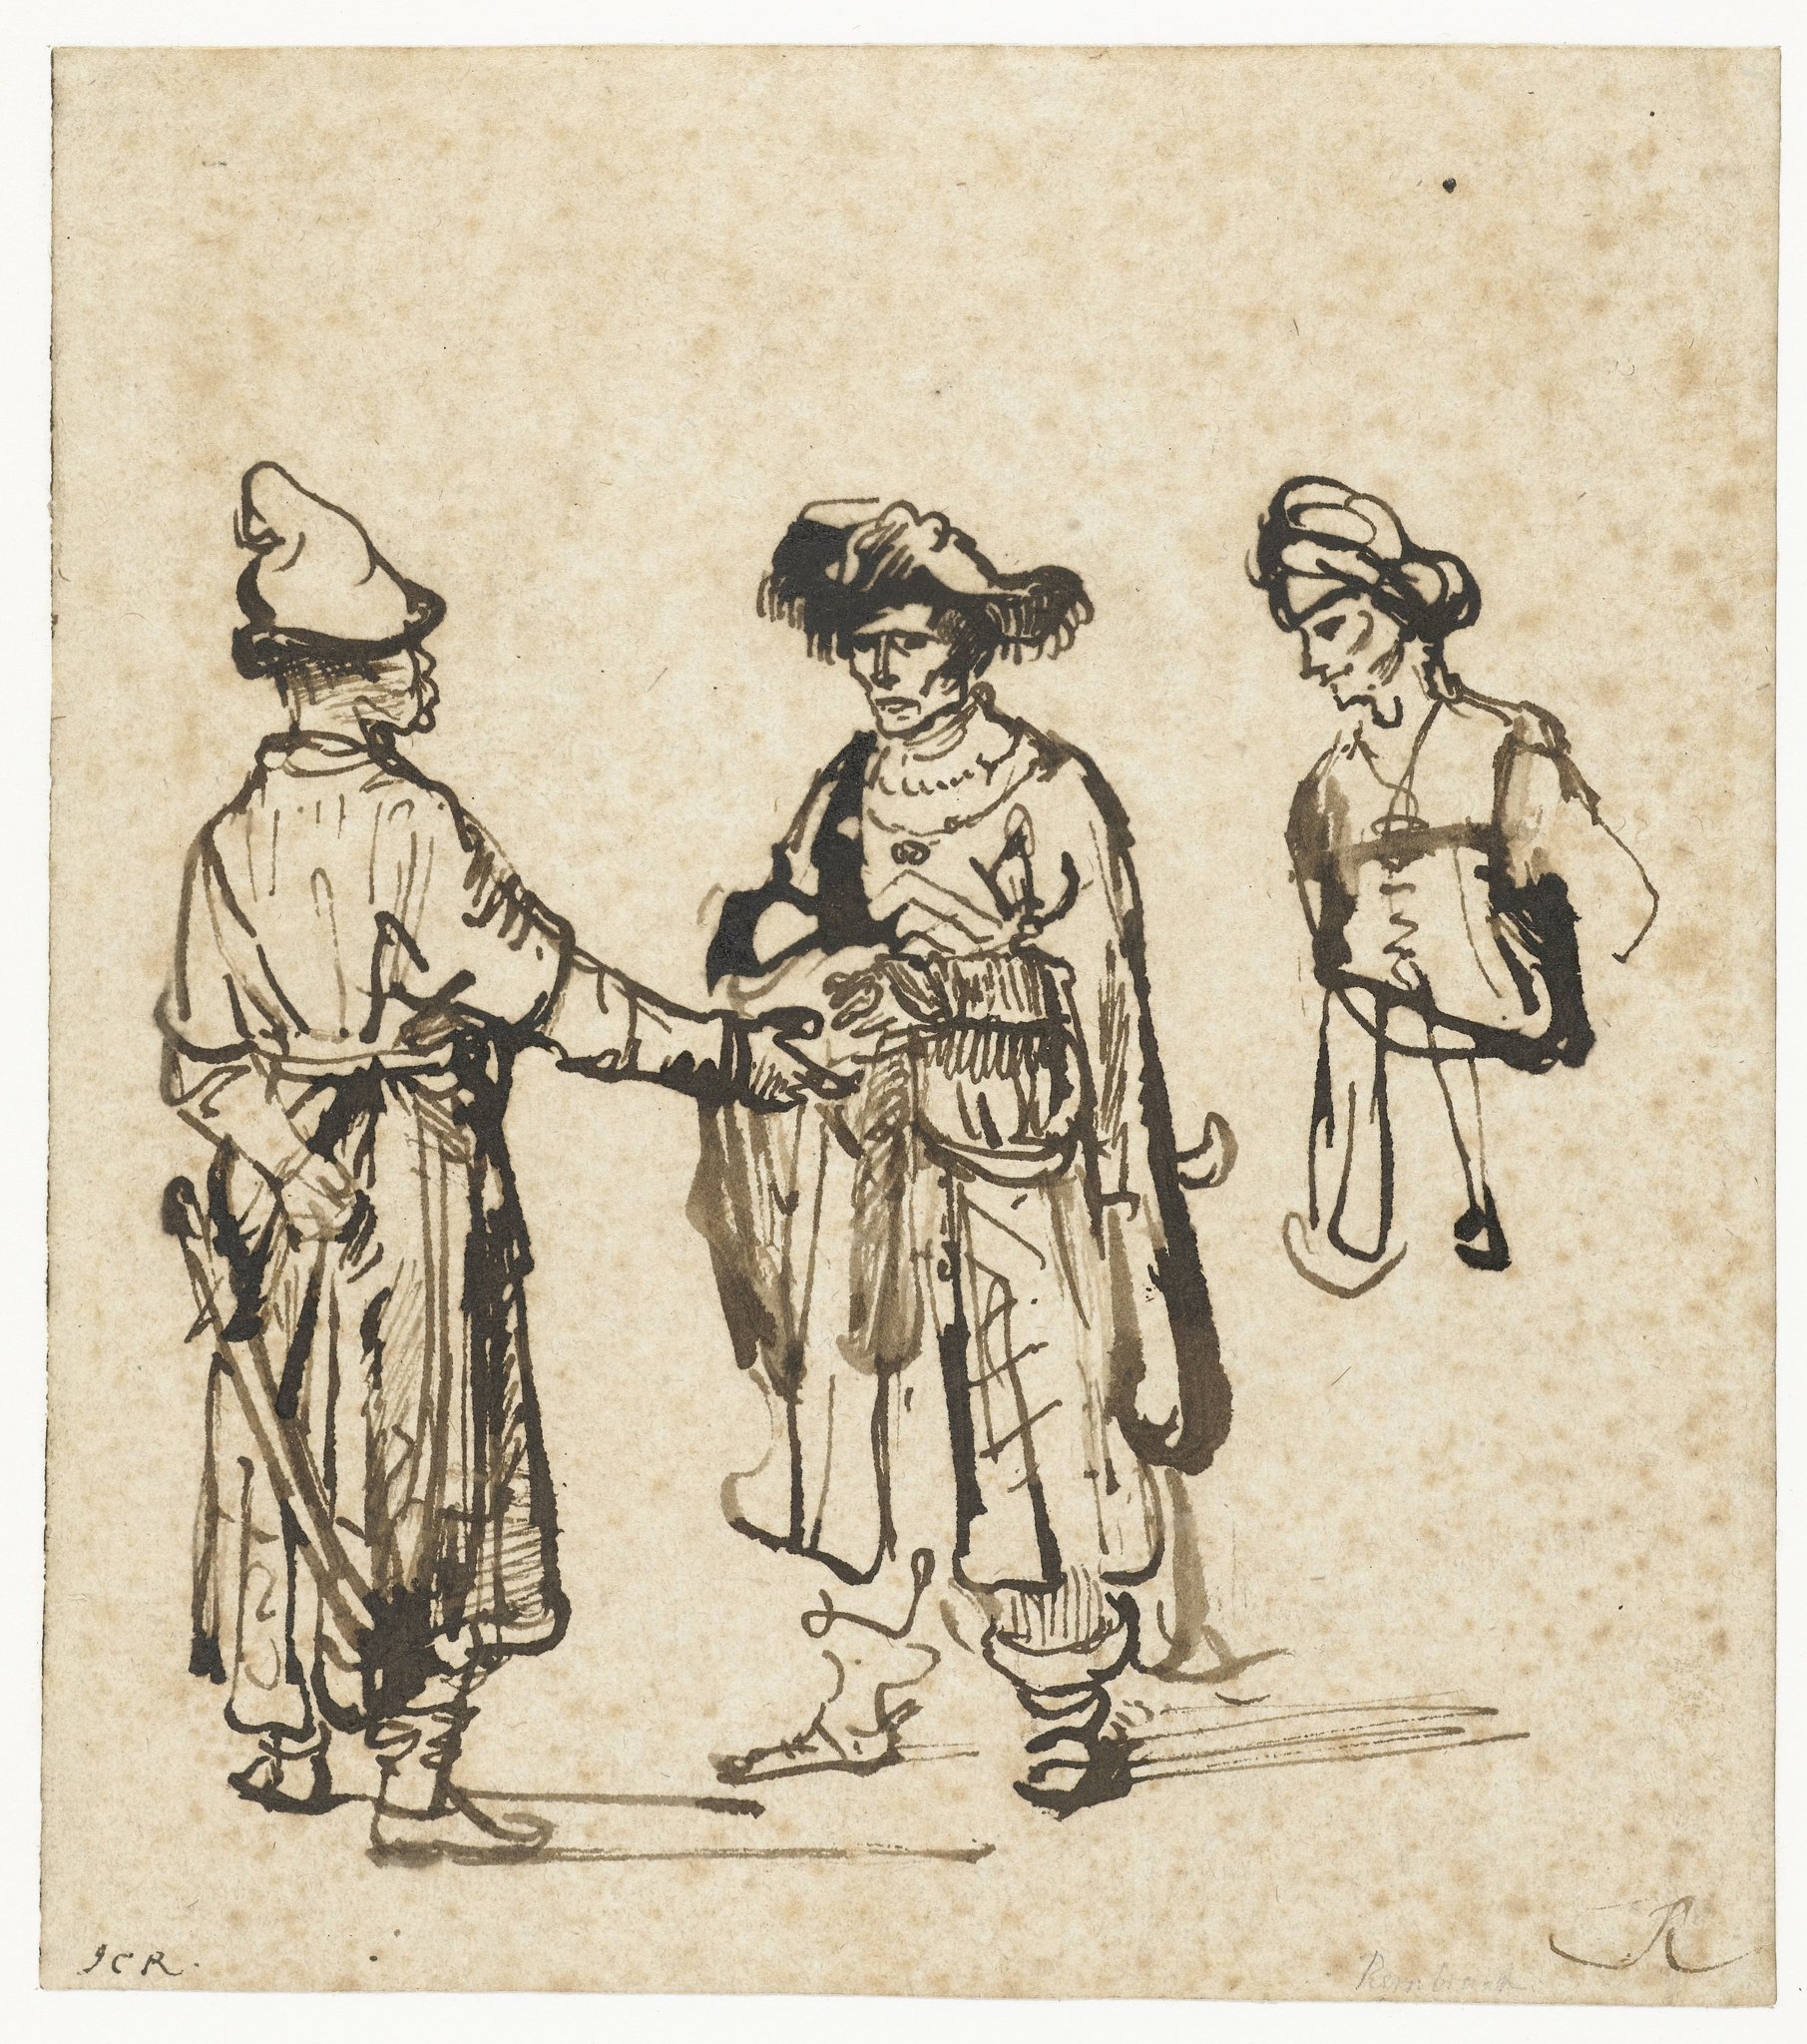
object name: drawing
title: Three Orientals Conversing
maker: rembrandt van rijn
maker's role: draughtsman, painter, print maker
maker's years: 1606-1669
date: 1645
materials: ink, paper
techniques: pen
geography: amsterdam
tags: asiatic races and peoples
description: In Rembrandt’s time, Amsterdam was an extremely cosmopolitan trade centre. Rembrandt was very interested in foreign types, especially in what have long been termed ‘Orientals’. For him, they probably represented biblical figures. He was especially intrigued by their faces and exotic clothing. He recorded them so that he could make the biblical scenes in his paintings and etchings as authentic as possible.